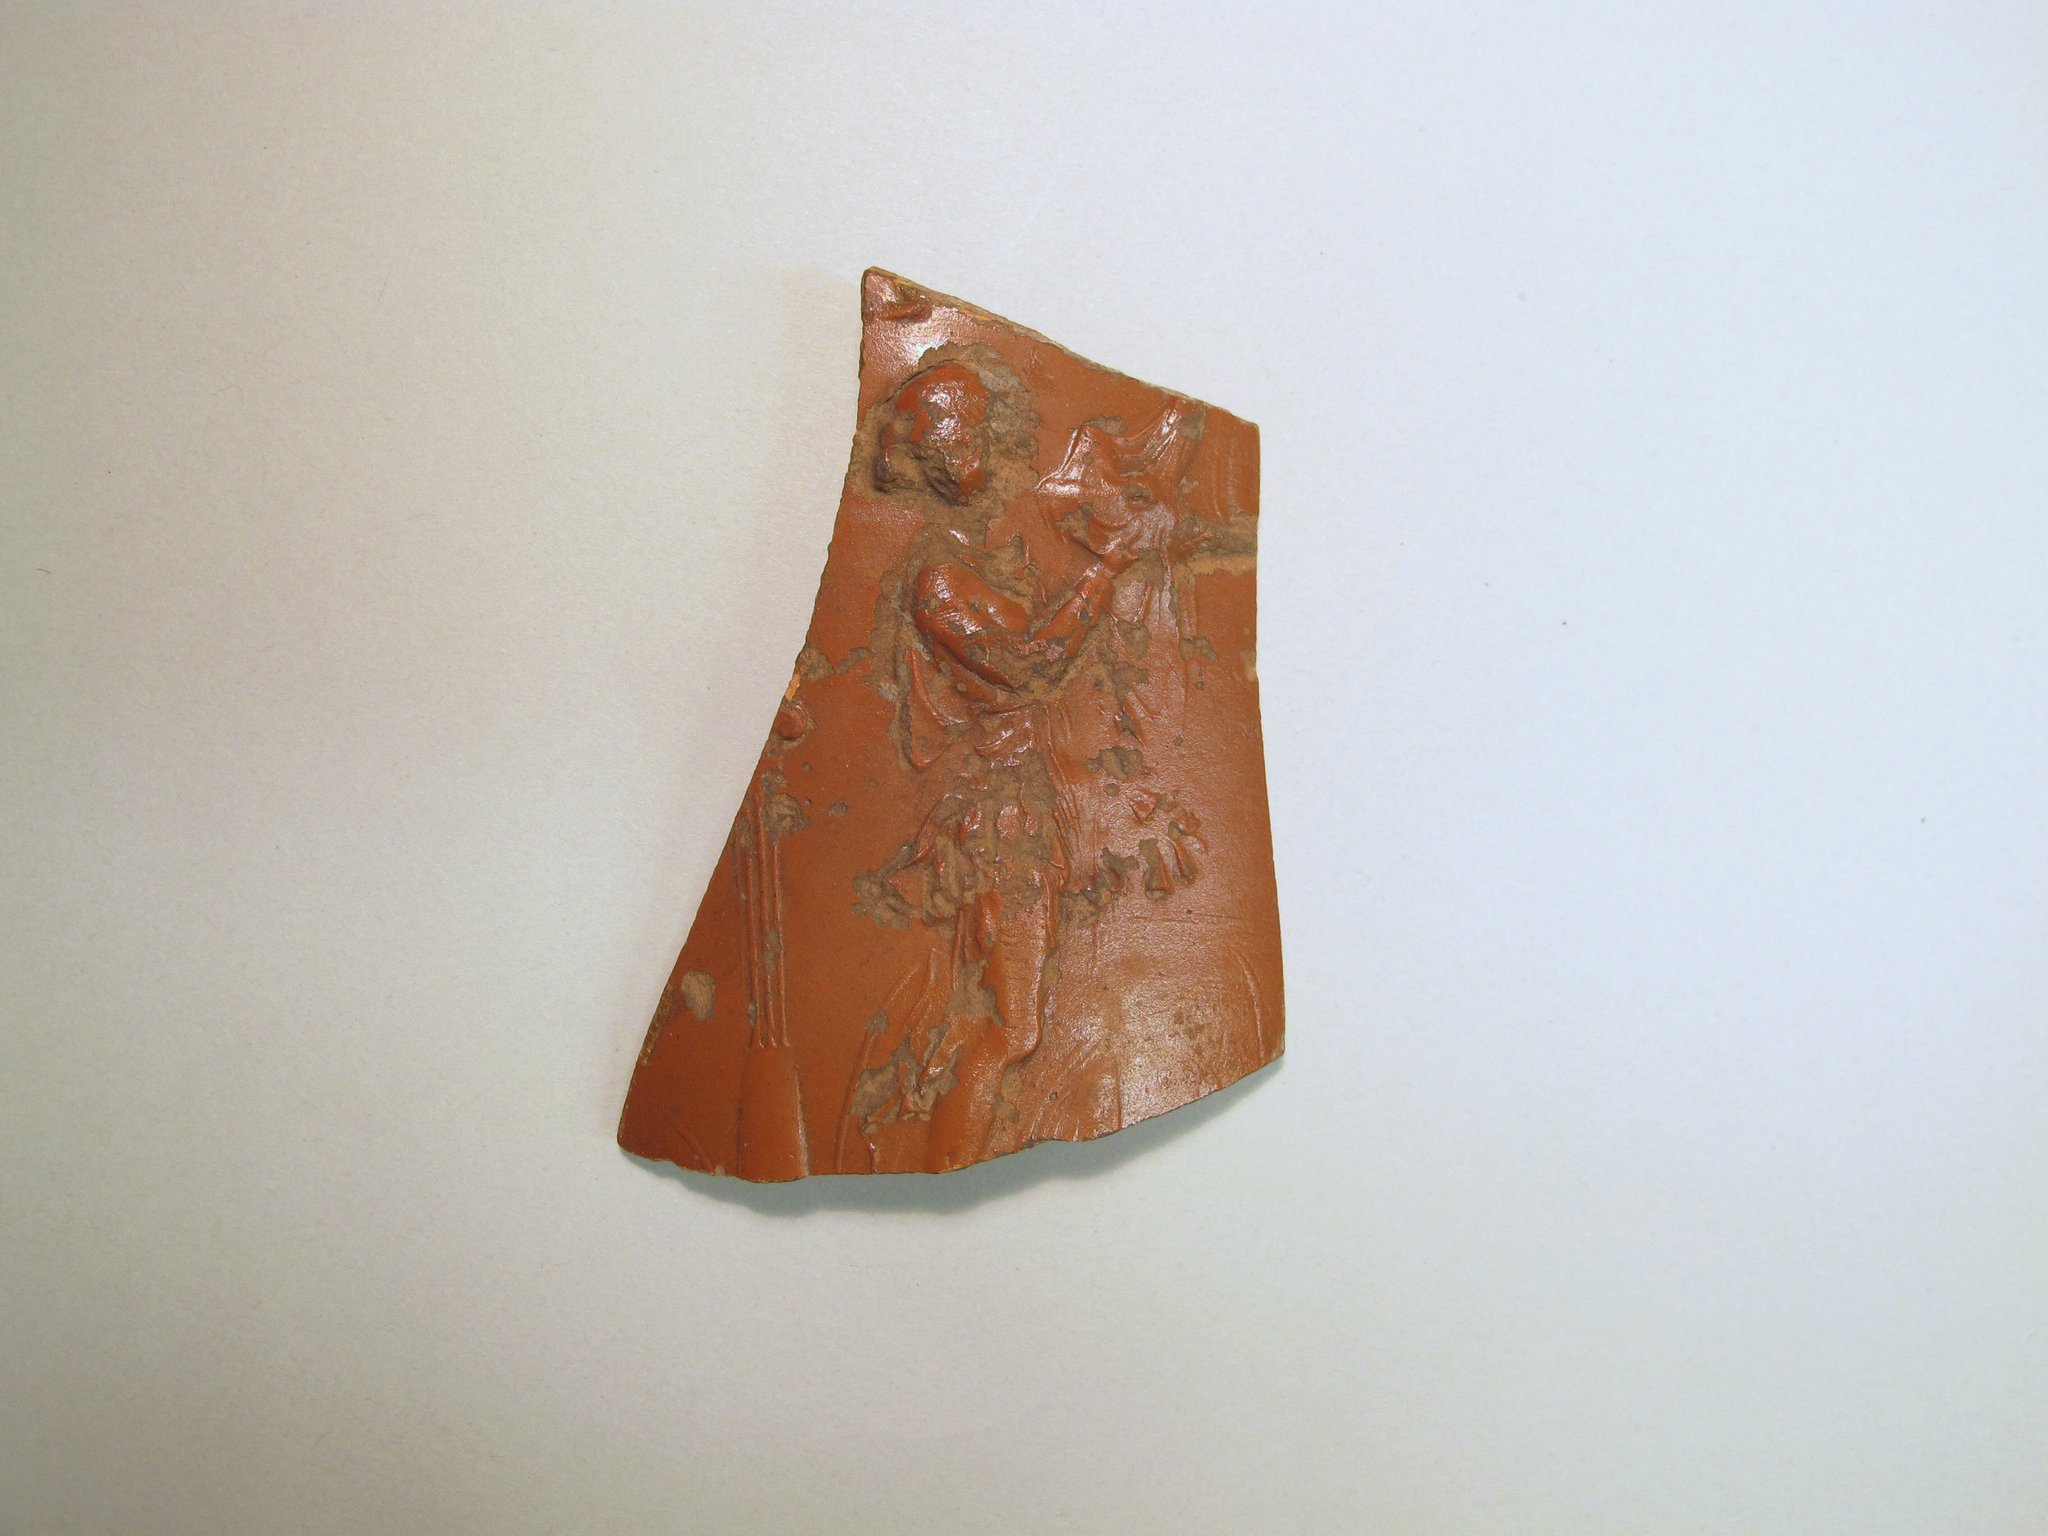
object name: cup, fragment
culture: roman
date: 670 BCE-330 CE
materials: terracotta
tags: musical instruments,musicians